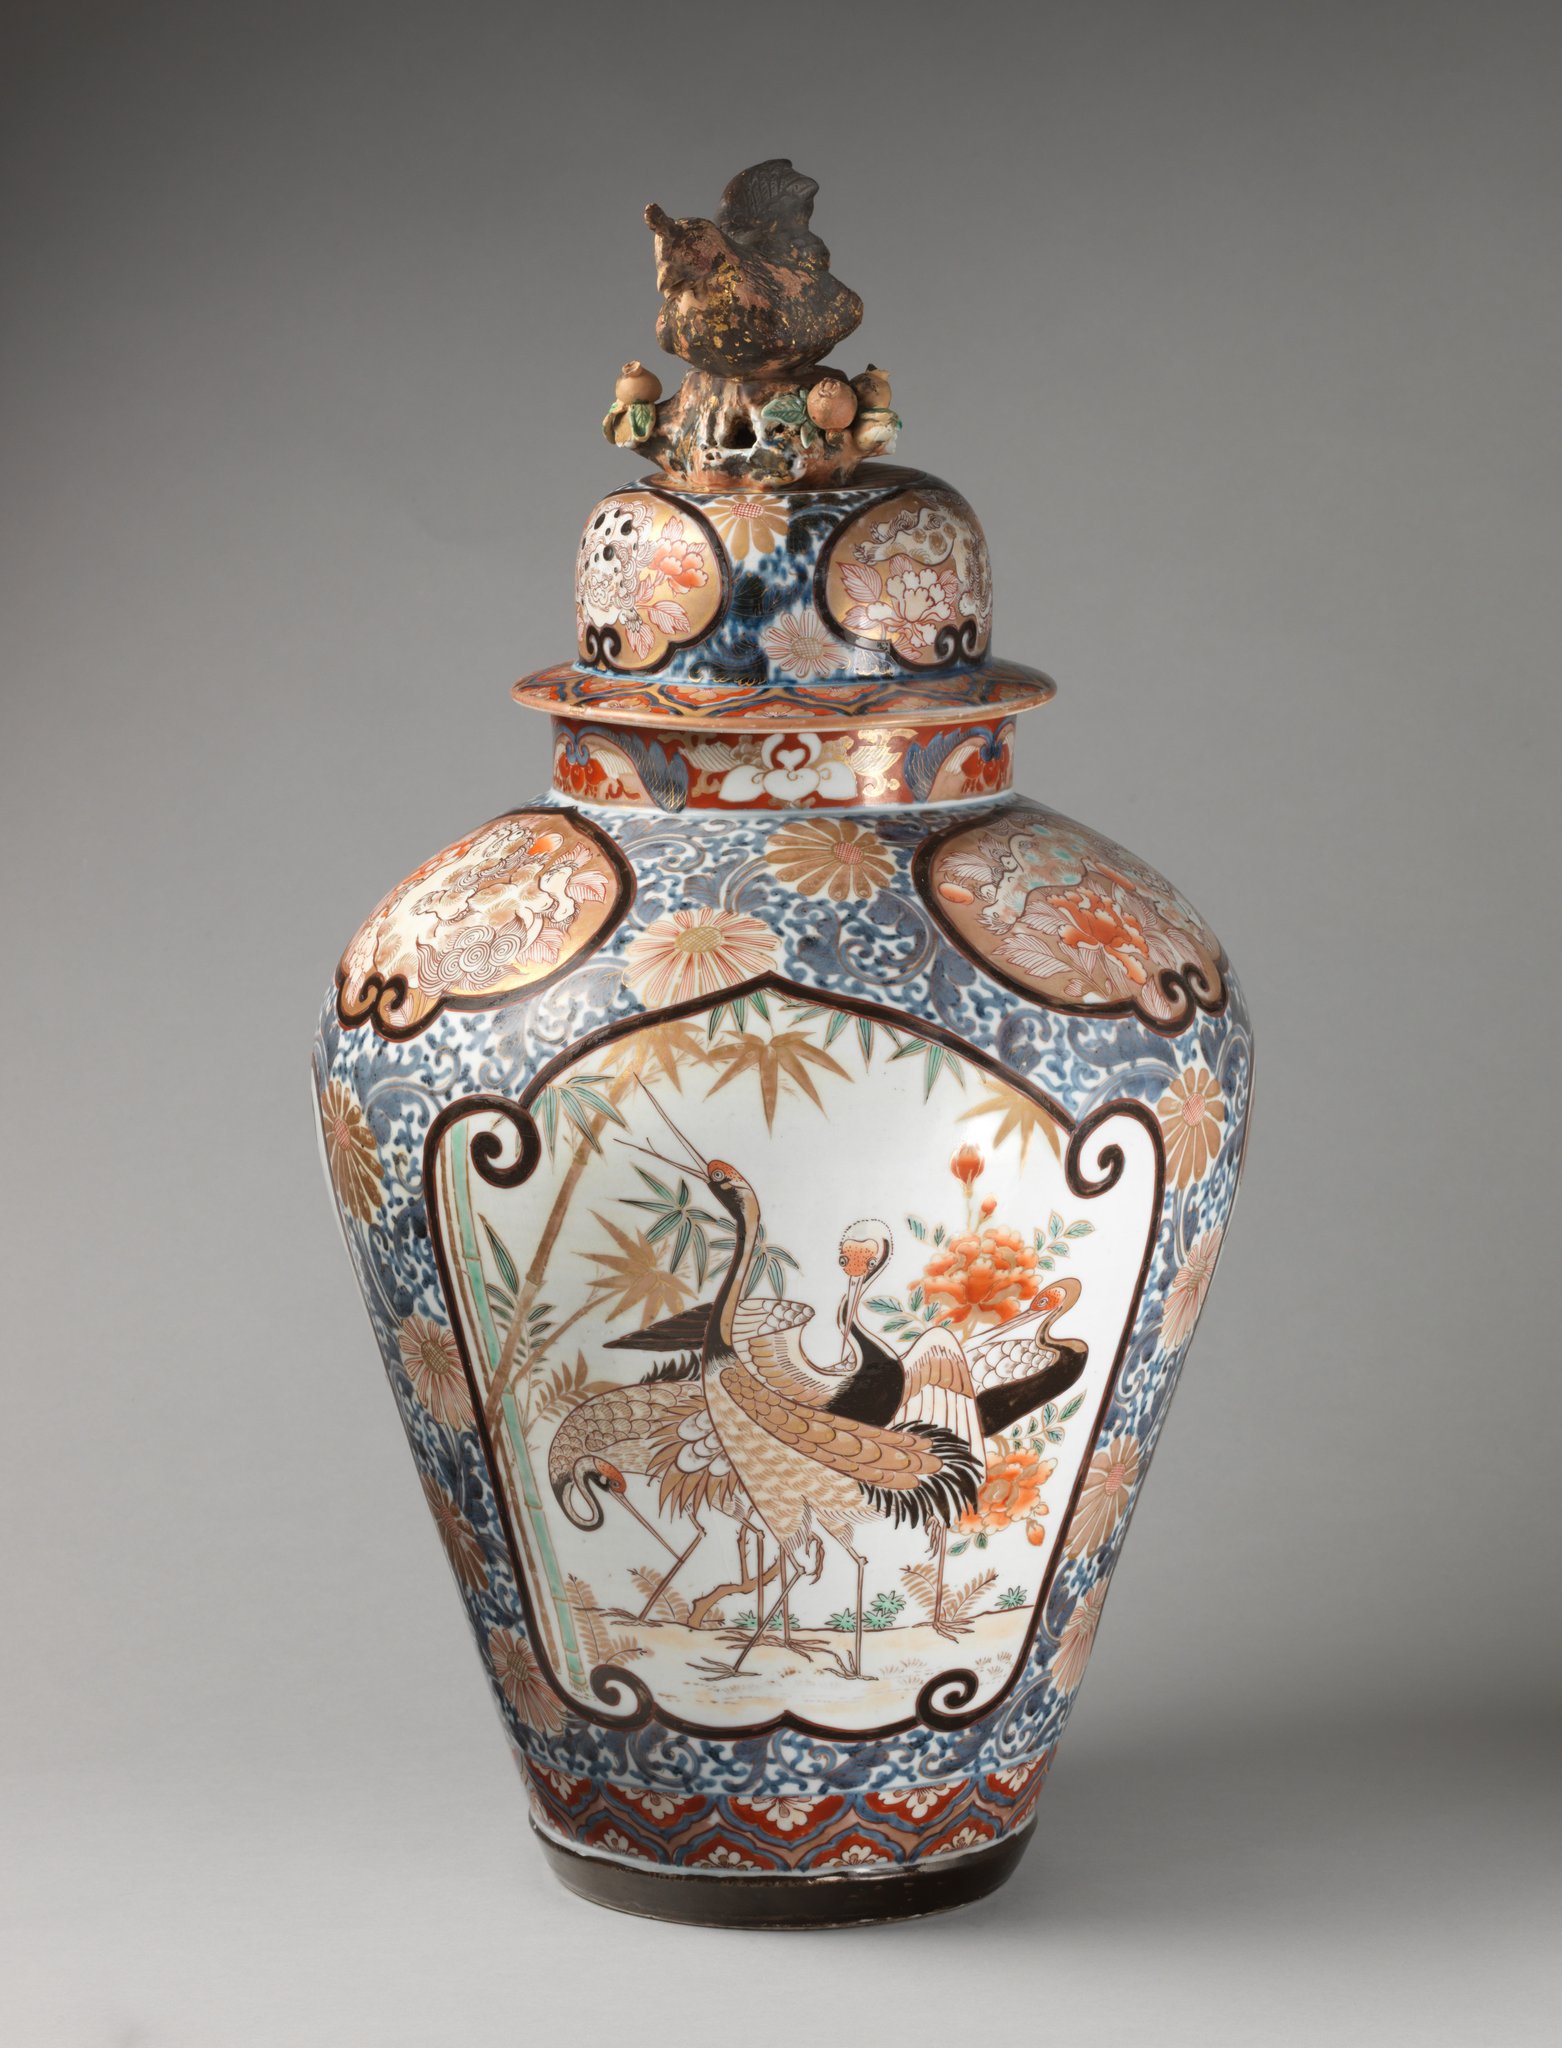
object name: vase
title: Baluster-shaped vase (part of an assembled garniture)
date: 1690-1720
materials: porcelain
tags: cranes